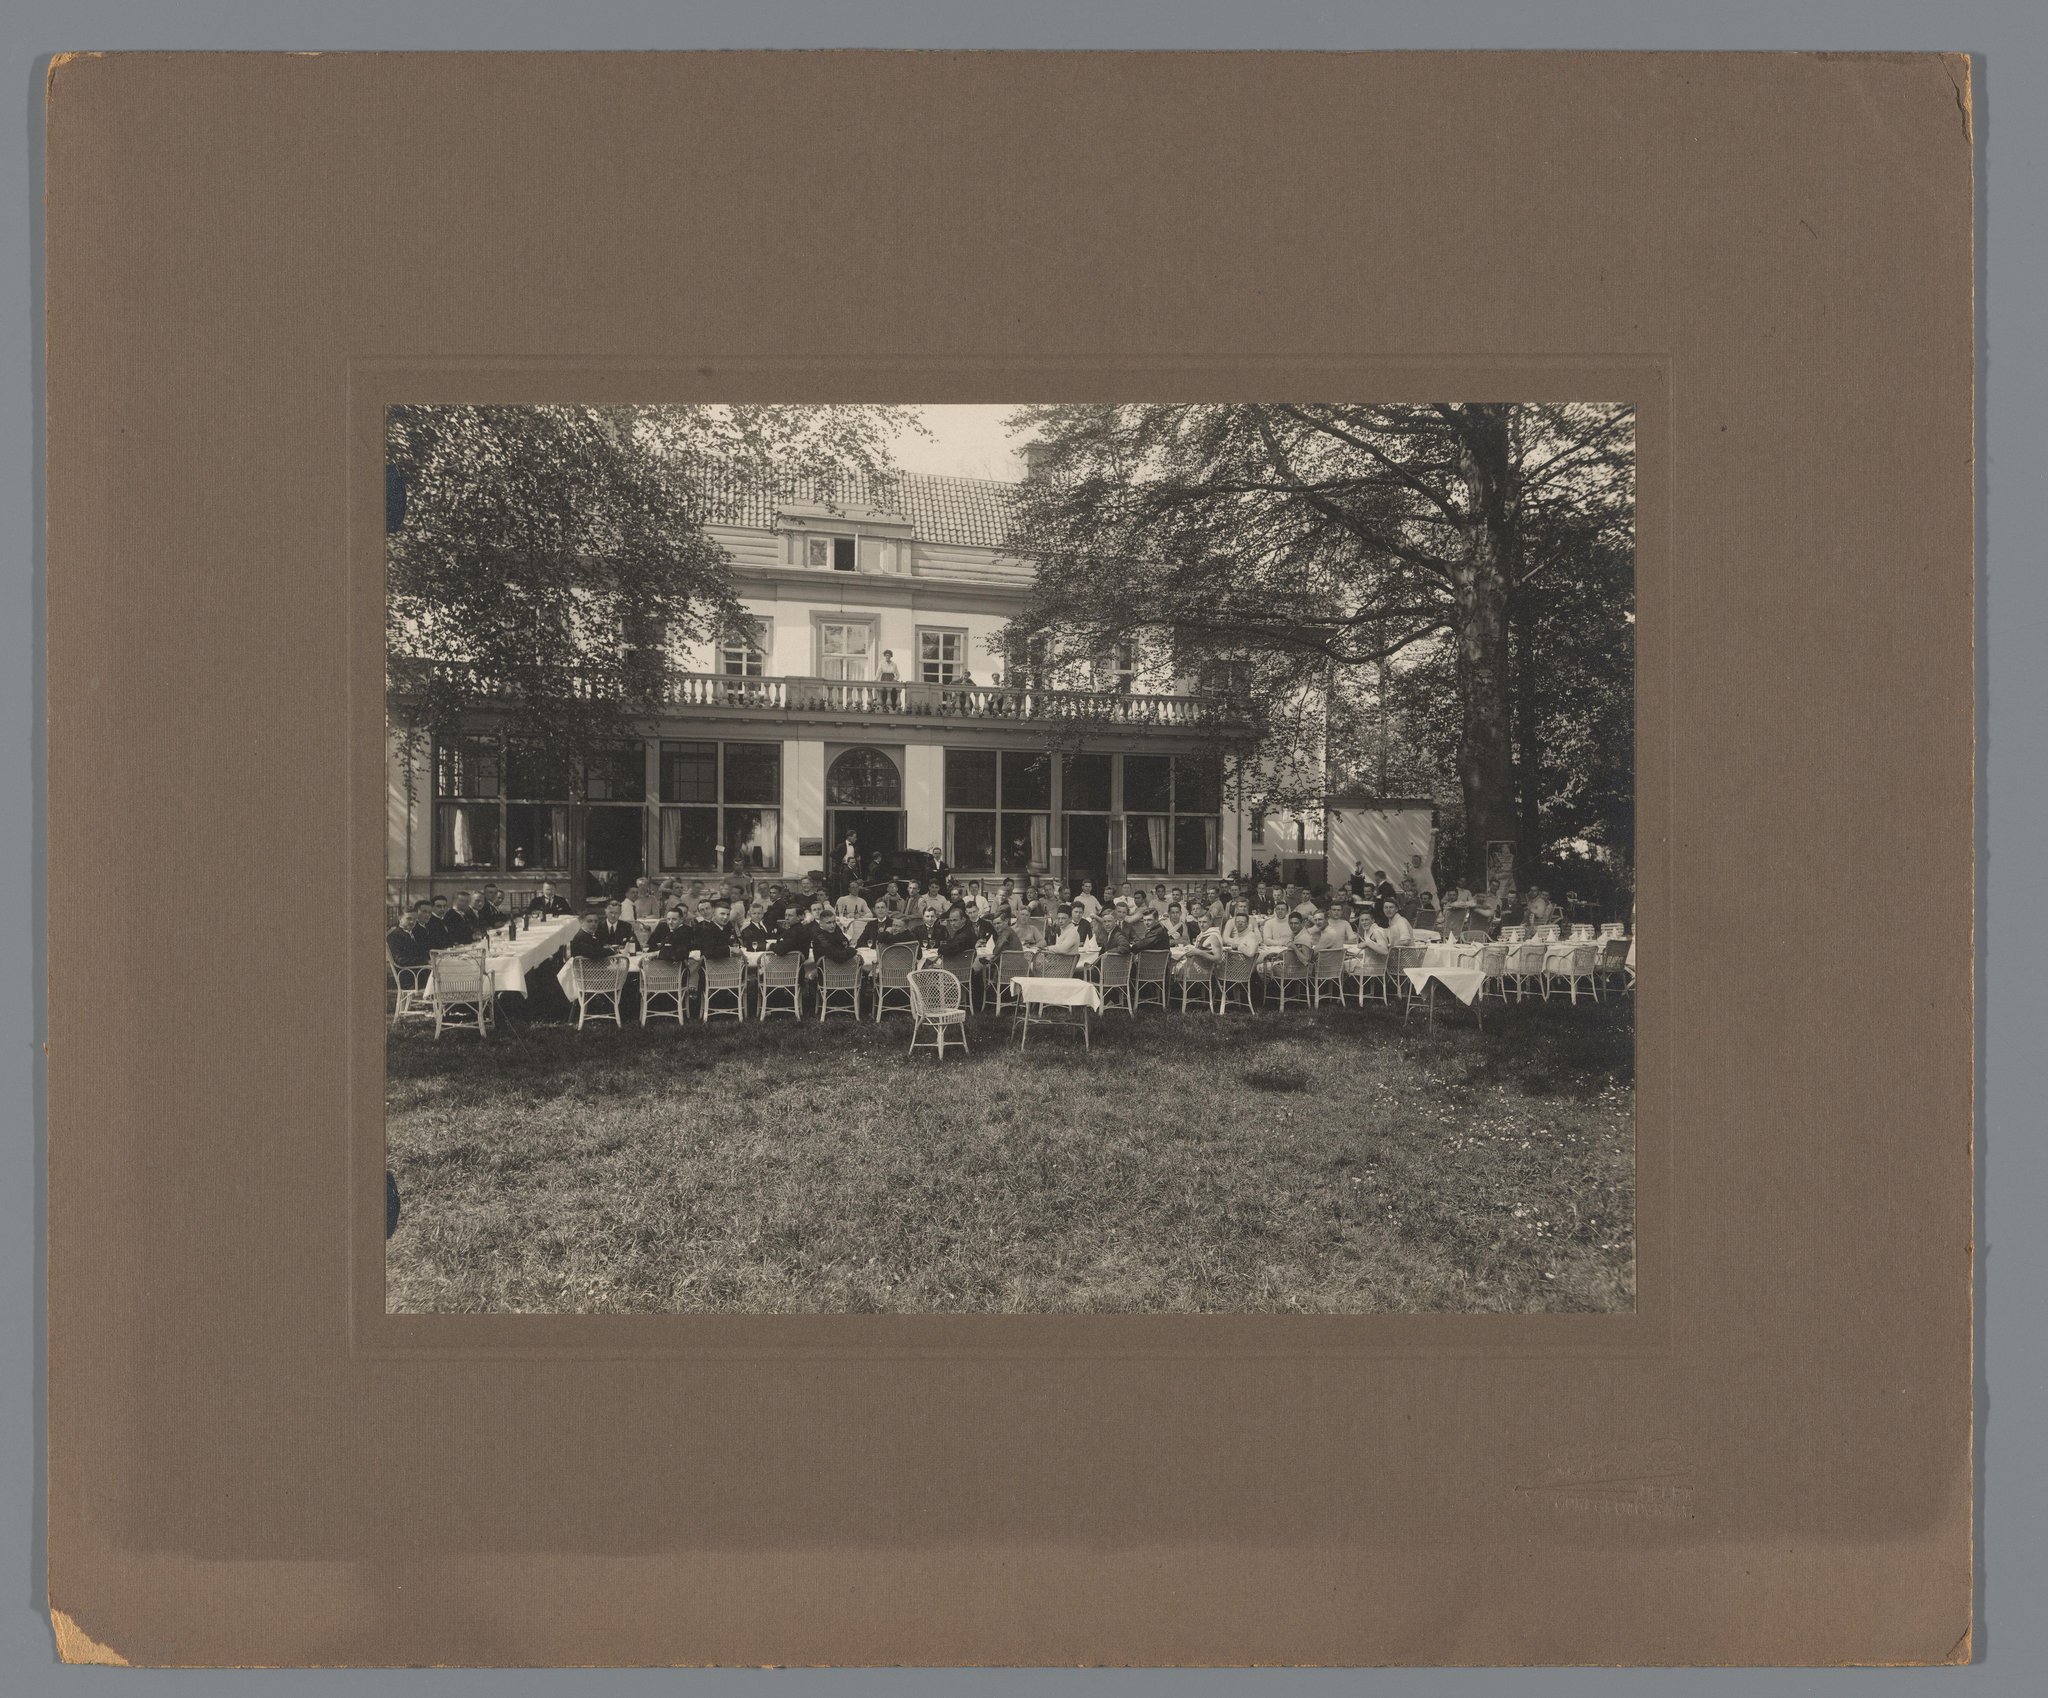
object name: photograph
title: Leden van roeivereniging Laga aan tafel de tuin van buitenplaats Vreugd en Rust te Voorburg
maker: j.c.c. witte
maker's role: fotograaf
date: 1915-1920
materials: paper, cardboard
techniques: gelatin silver print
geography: voorburg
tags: rowing facing backward, pulling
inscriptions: inscription: ‘Vreugd-Rust/ Voorburg.’